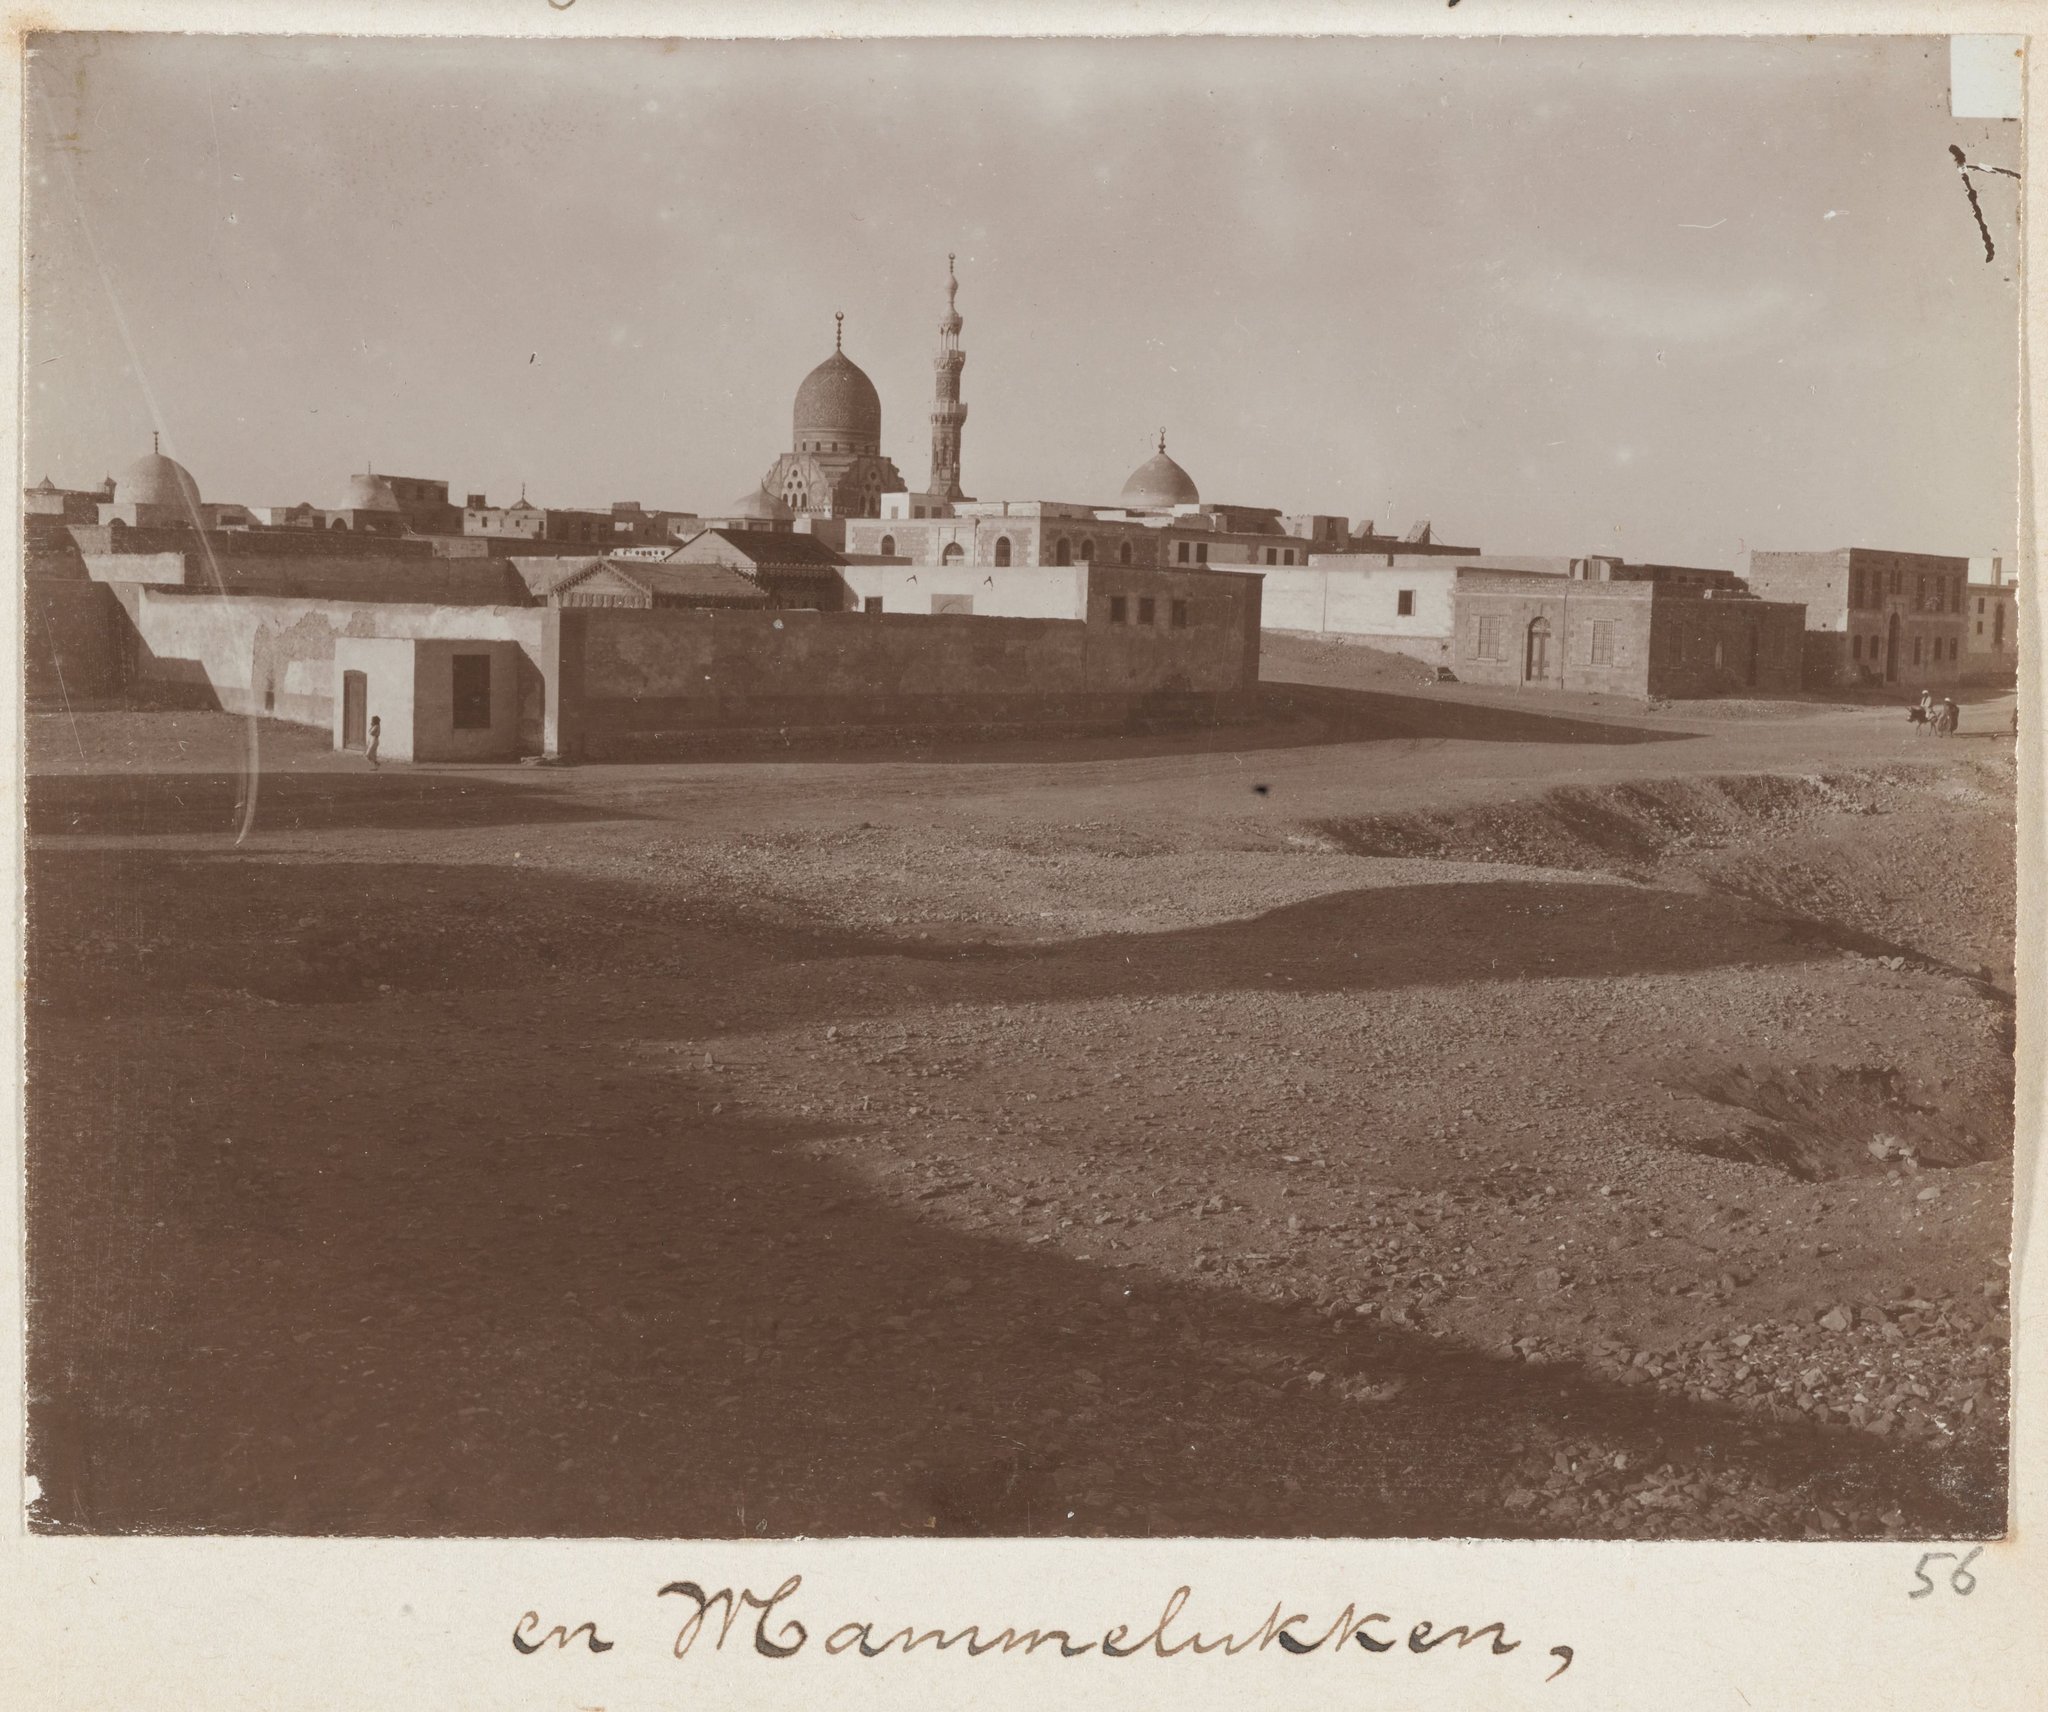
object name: photograph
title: Gezicht op het Qarafa in Caïro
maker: johannes lodewijk heldring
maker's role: fotograaf, predikant, schrijver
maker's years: 1852-1923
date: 1898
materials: paper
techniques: collodion silver print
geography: cairo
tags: grave-building, monumental tomb